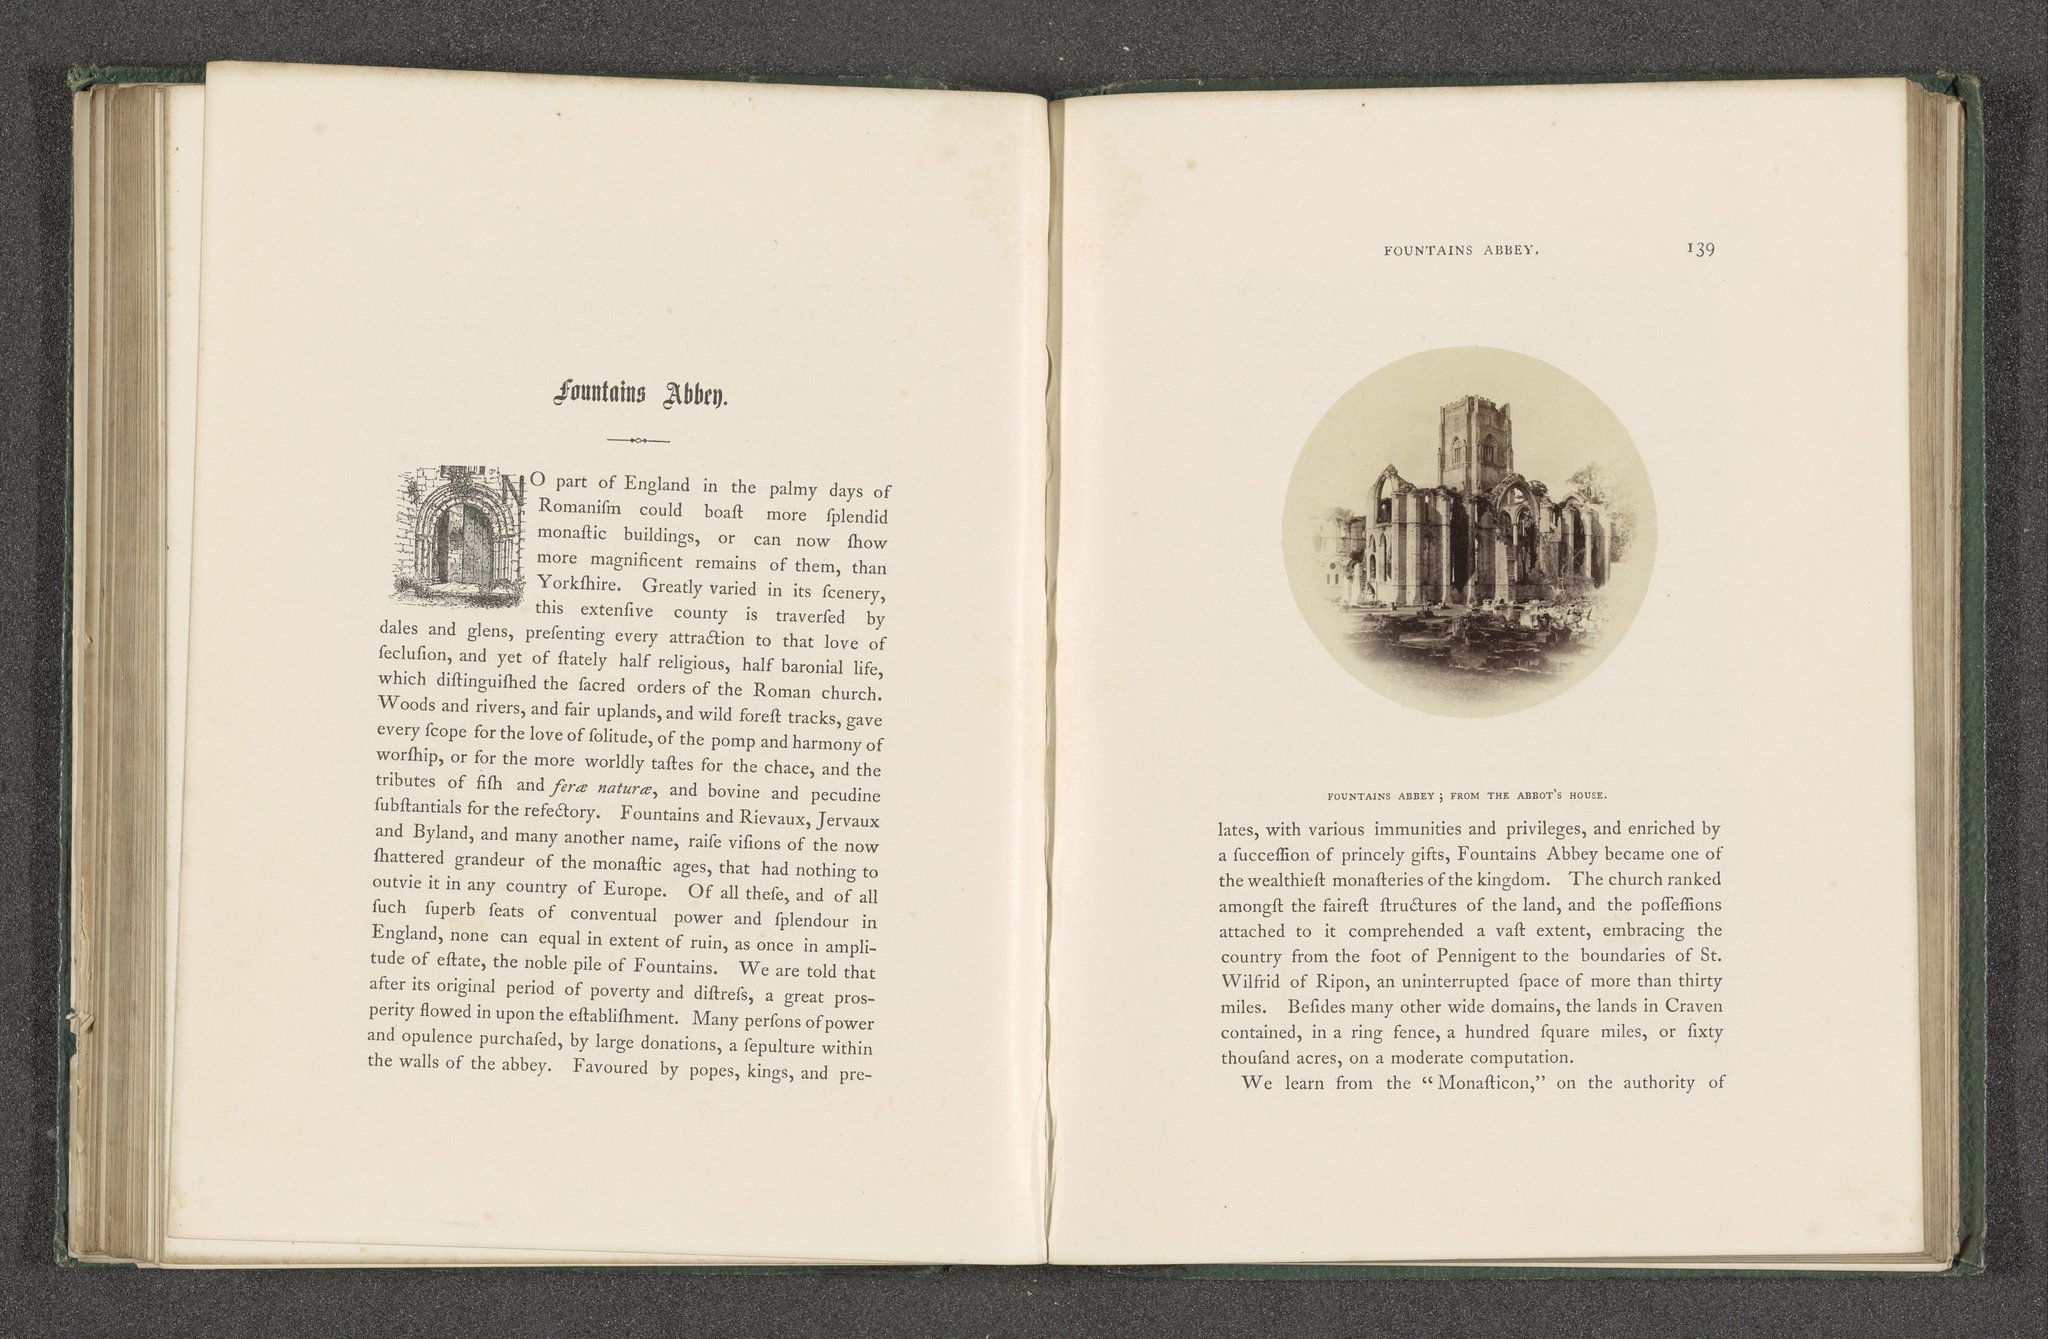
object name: page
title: Fountains Abbey ; from the Abbot's House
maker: william russell sedgfield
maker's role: fotograaf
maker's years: 1826-1902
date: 1852-1862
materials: photographic support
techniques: albumen print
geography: fountains abbey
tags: ruin of church, monastery, etc.